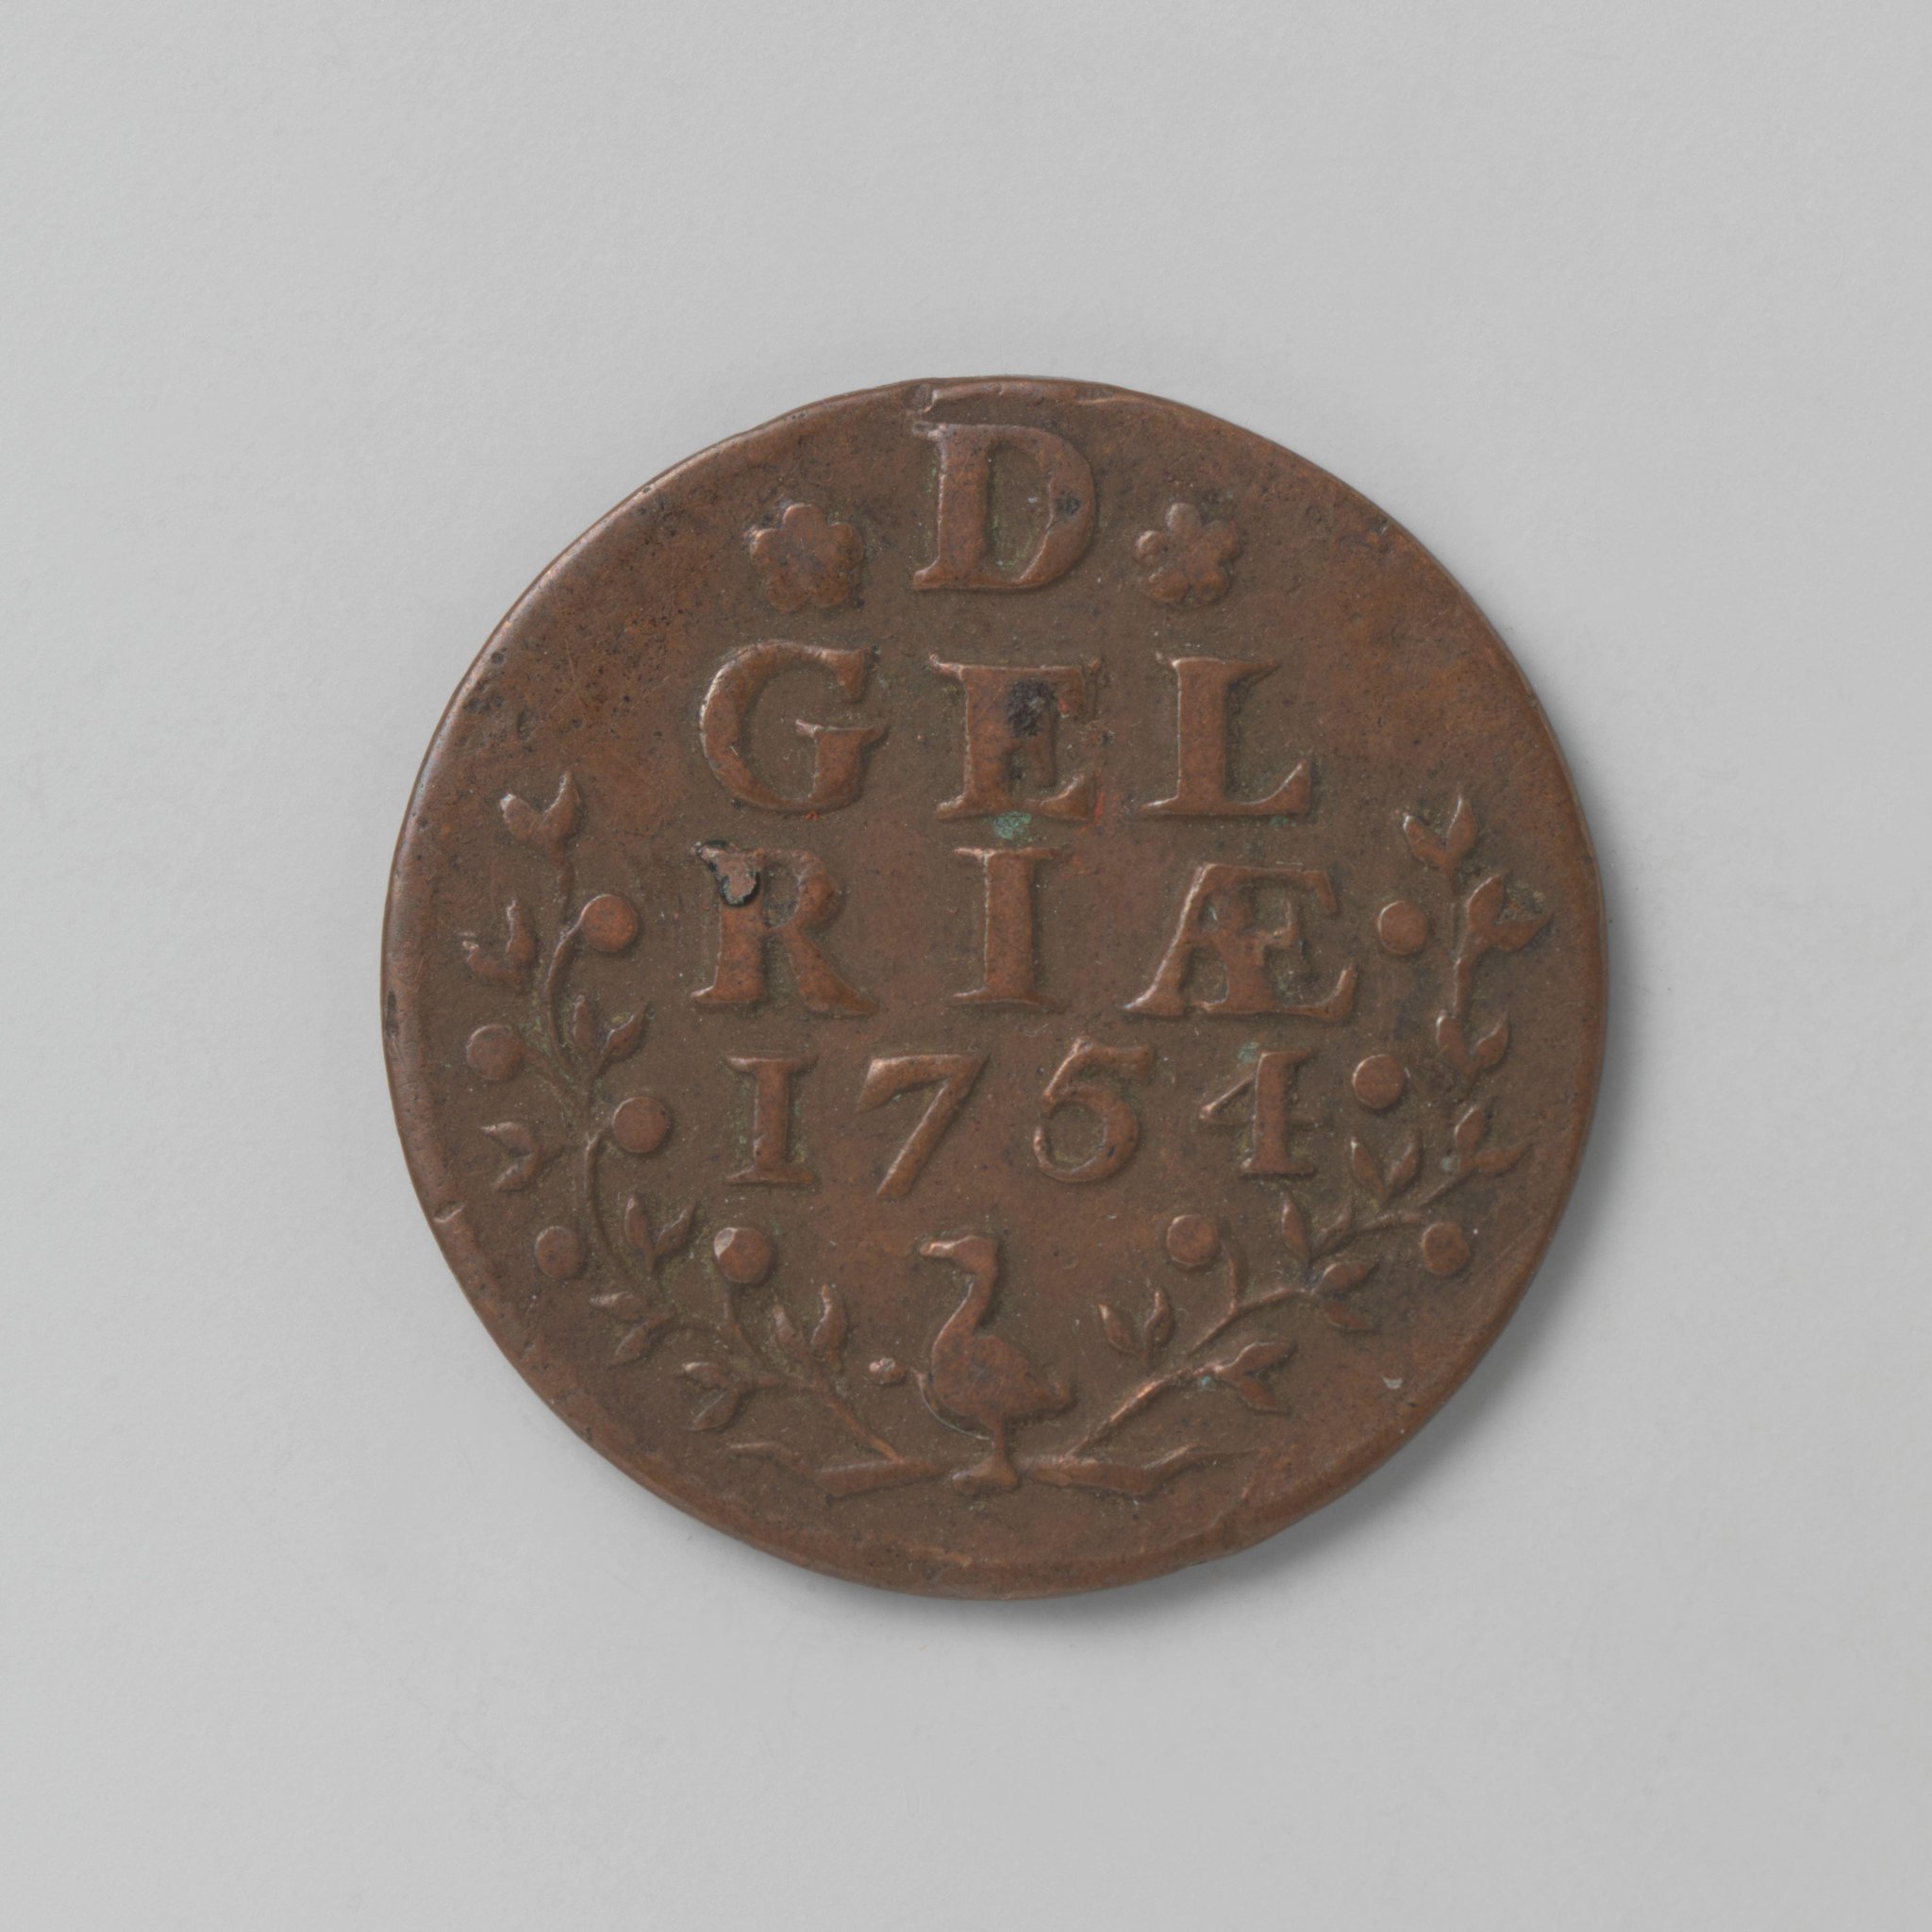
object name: coin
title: Gelderland, duit, 1754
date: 1754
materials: copper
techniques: striking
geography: harderwijk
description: Koperen munt. Voorzijde: binnen versiering in drie regels D/GEL/RIAE, daaronder jaartal en muntmeesterteken. Keerzijde: gekroond Gelders wapenschild.